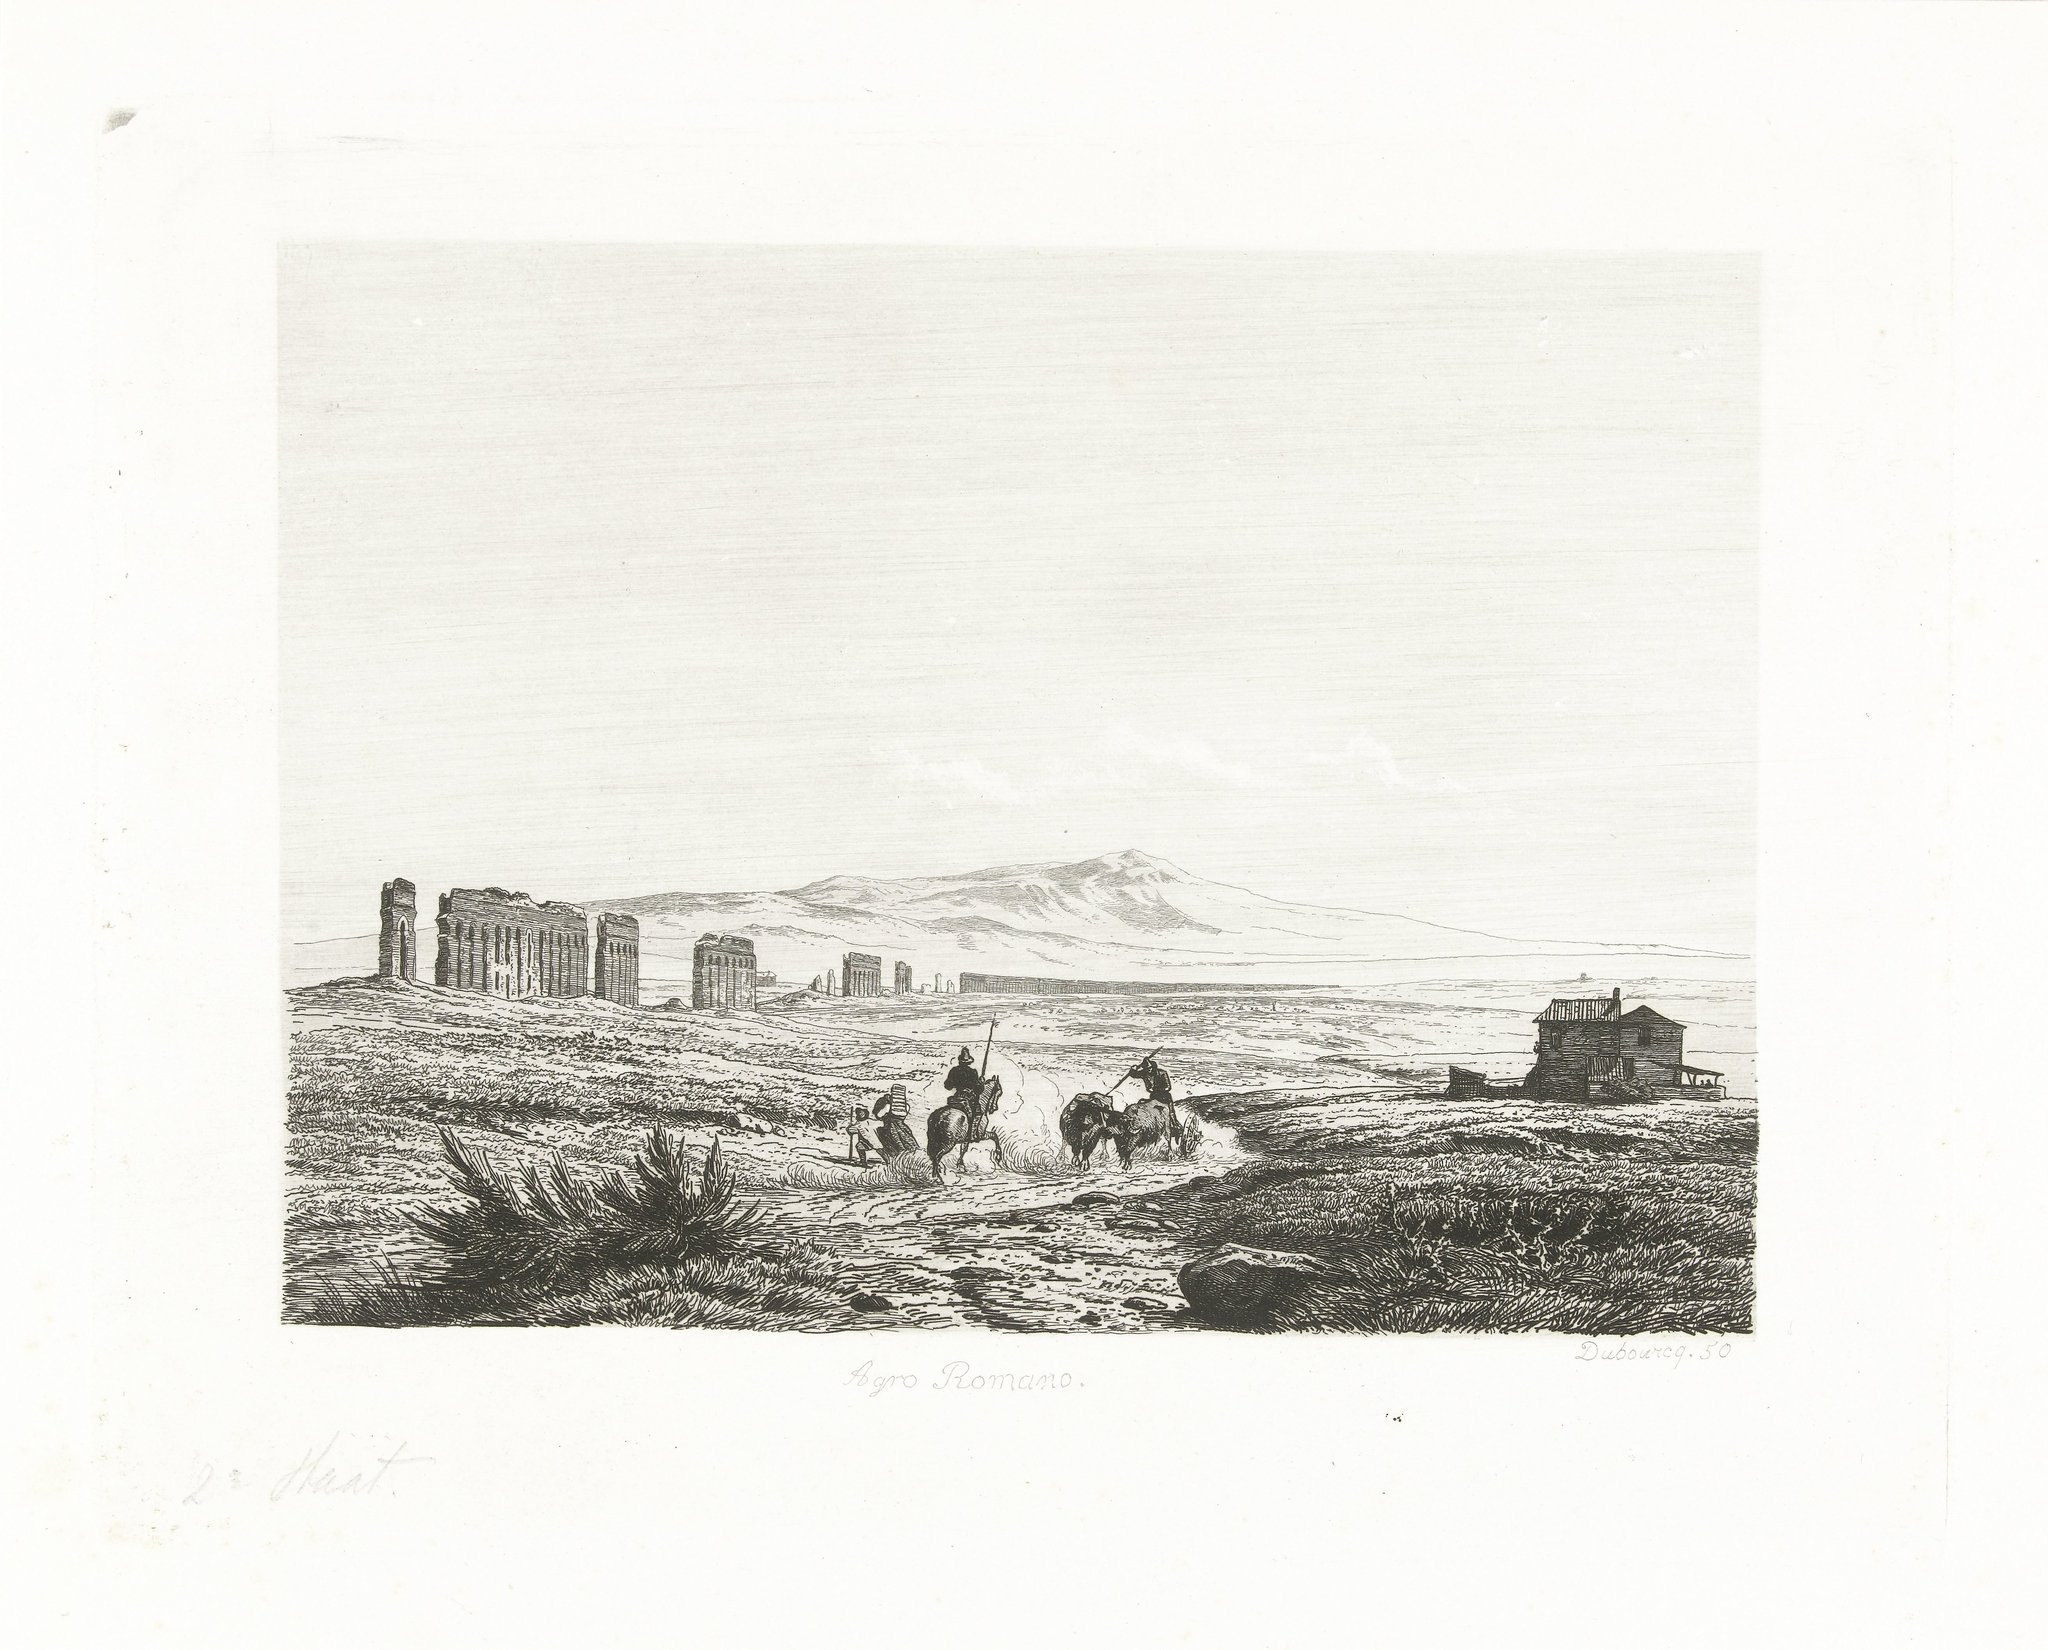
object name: print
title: Zes etsproeven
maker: pierre louis dubourcq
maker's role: draughtsman, painter, print maker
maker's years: 1815-1873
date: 1850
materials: paper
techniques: etching, intaglio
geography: netherlands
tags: landscape with ruins, rome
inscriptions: collector's mark: Lugt 2228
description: Een ruiter en een boer met een ossenkar in de open vlakte bij overblijfselen van een Romeins aquaduct. Rechts een huis.